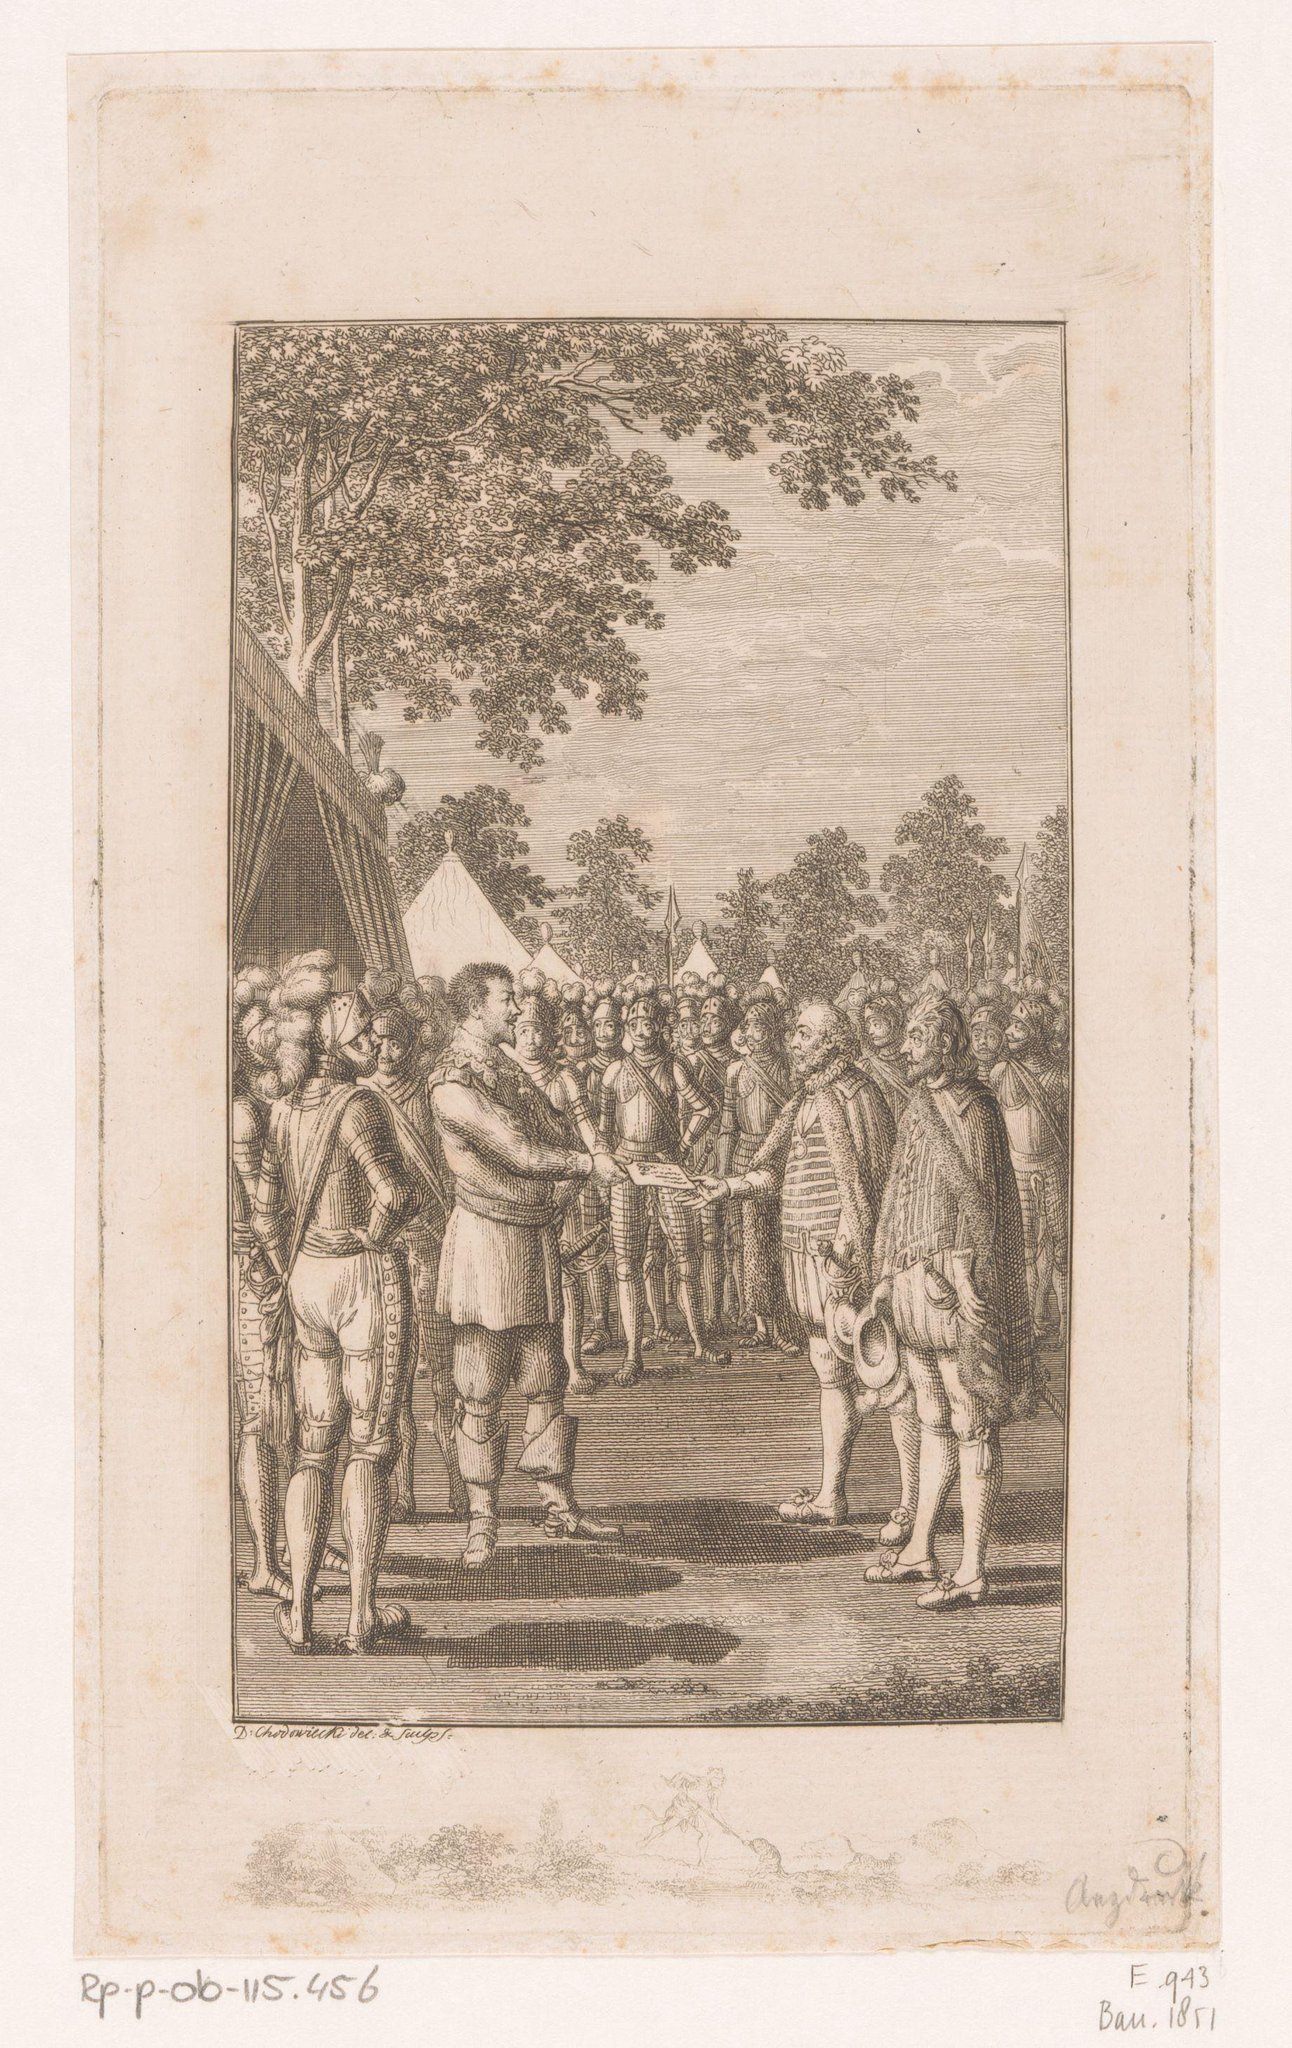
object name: print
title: Ferdinand II neemt het document van Albrecht van Wallenstein in ontvangst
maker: daniel nikolaus chodowiecki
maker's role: draughtsman, print maker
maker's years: 1726-1801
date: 1800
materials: paper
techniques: etching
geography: berlin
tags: vienna, ferdinand ii (duits keizer), (military) camp with tents, history, ruler, sovereign, letter, envelope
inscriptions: collector's mark: Lugt 2228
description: Prent gebruikt voor: Deutsche Monatsschrift (...). Leipzig: Sommersche Buchhandlung, 1800.